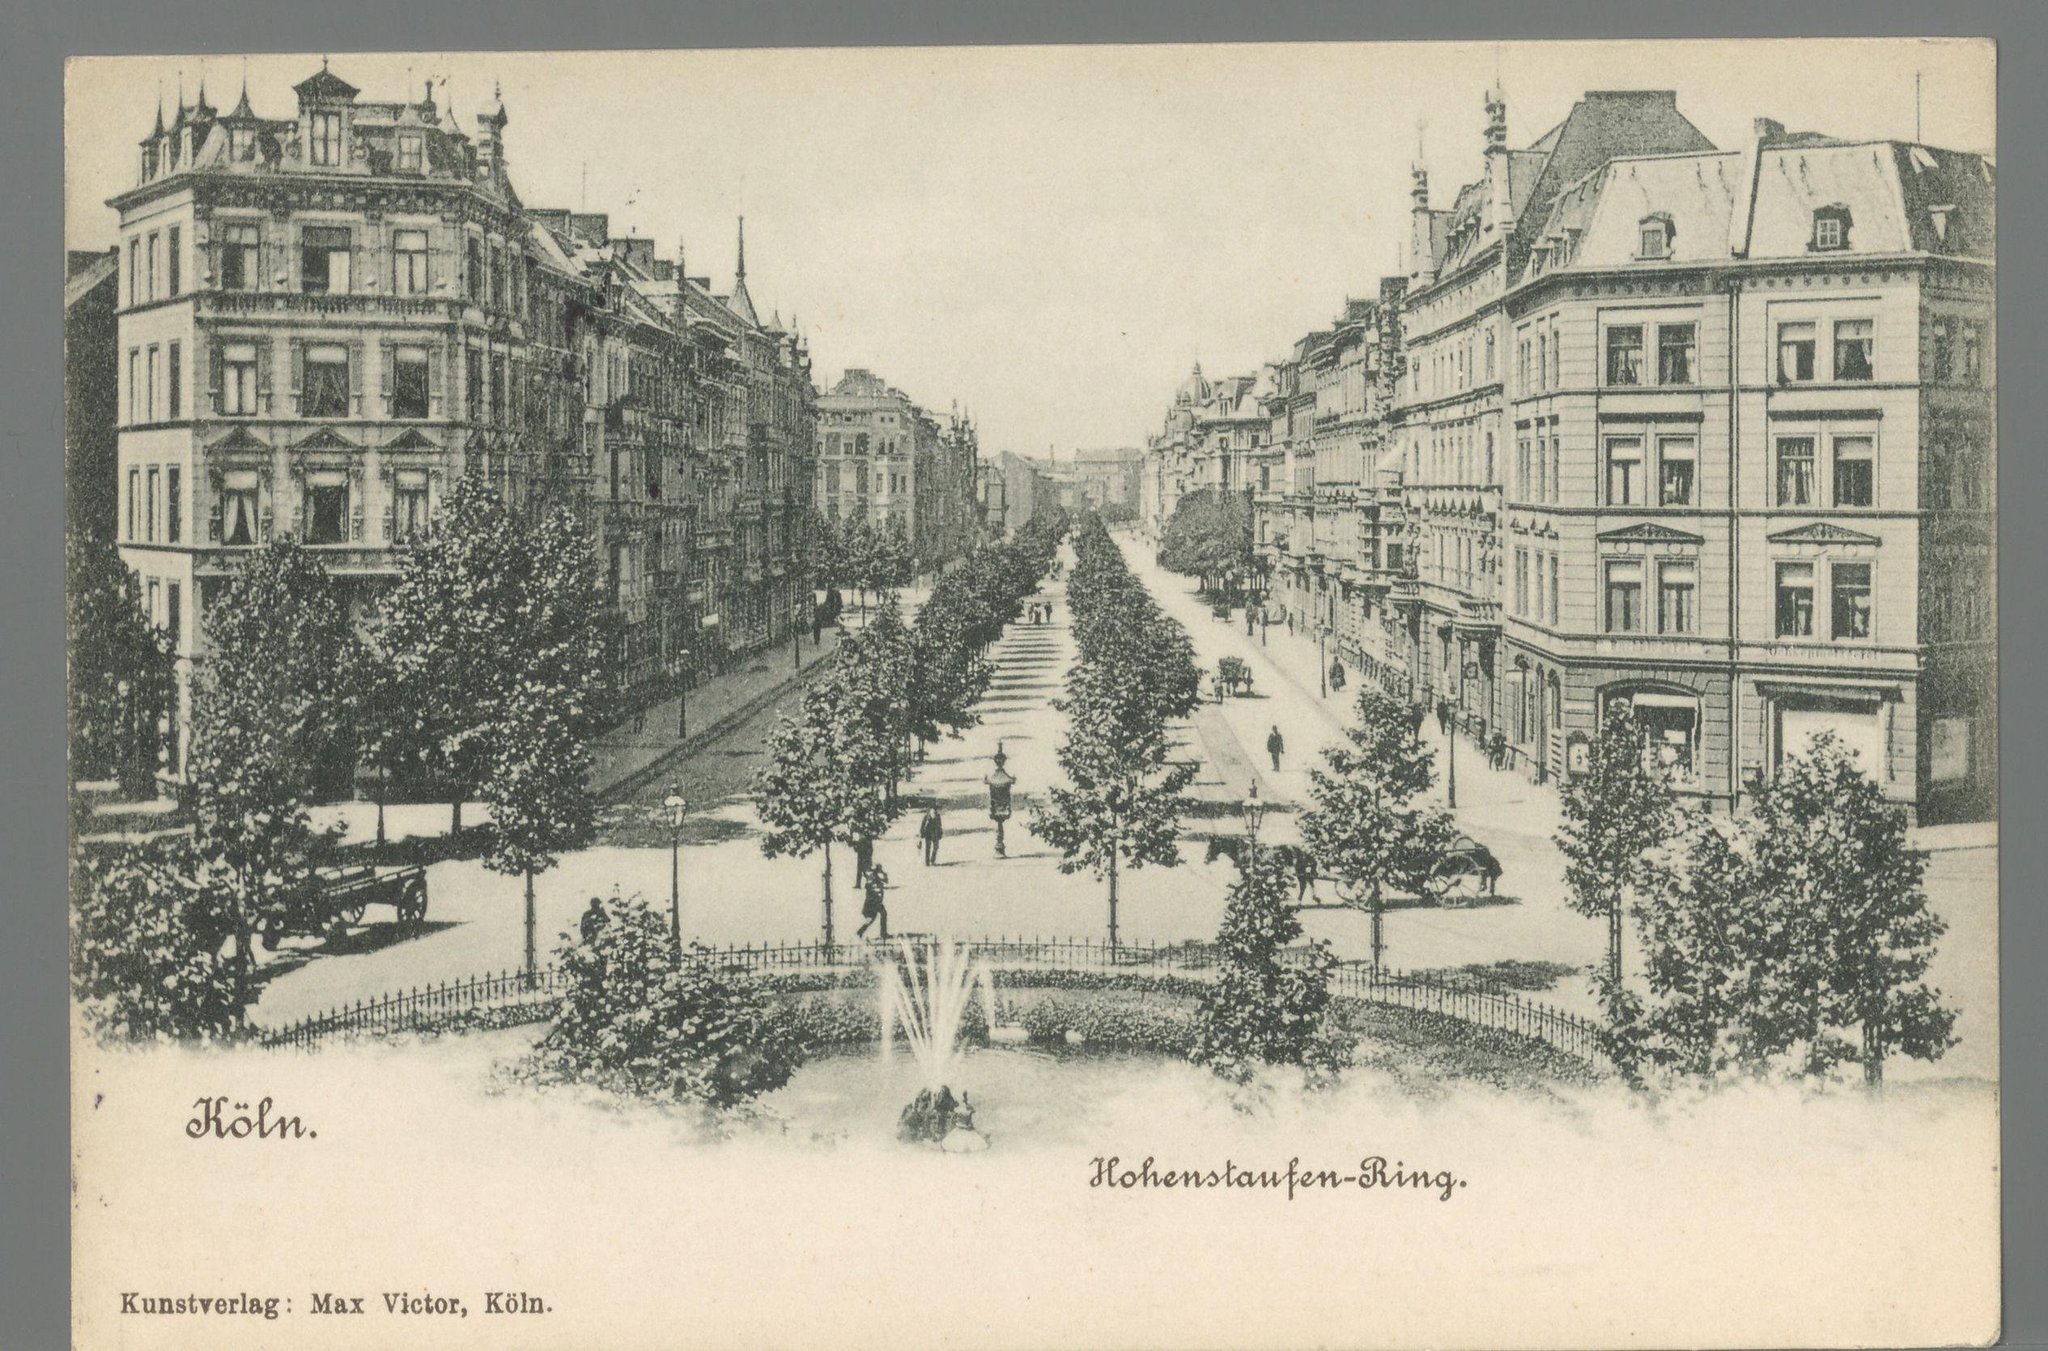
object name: ansichtkaart, prentbriefkaart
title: Köln. Hohenstaufen-Ring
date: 1885-1902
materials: cardboard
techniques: photograph, writing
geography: cologne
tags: ornamental fountain, street, cologne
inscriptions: postage stamp